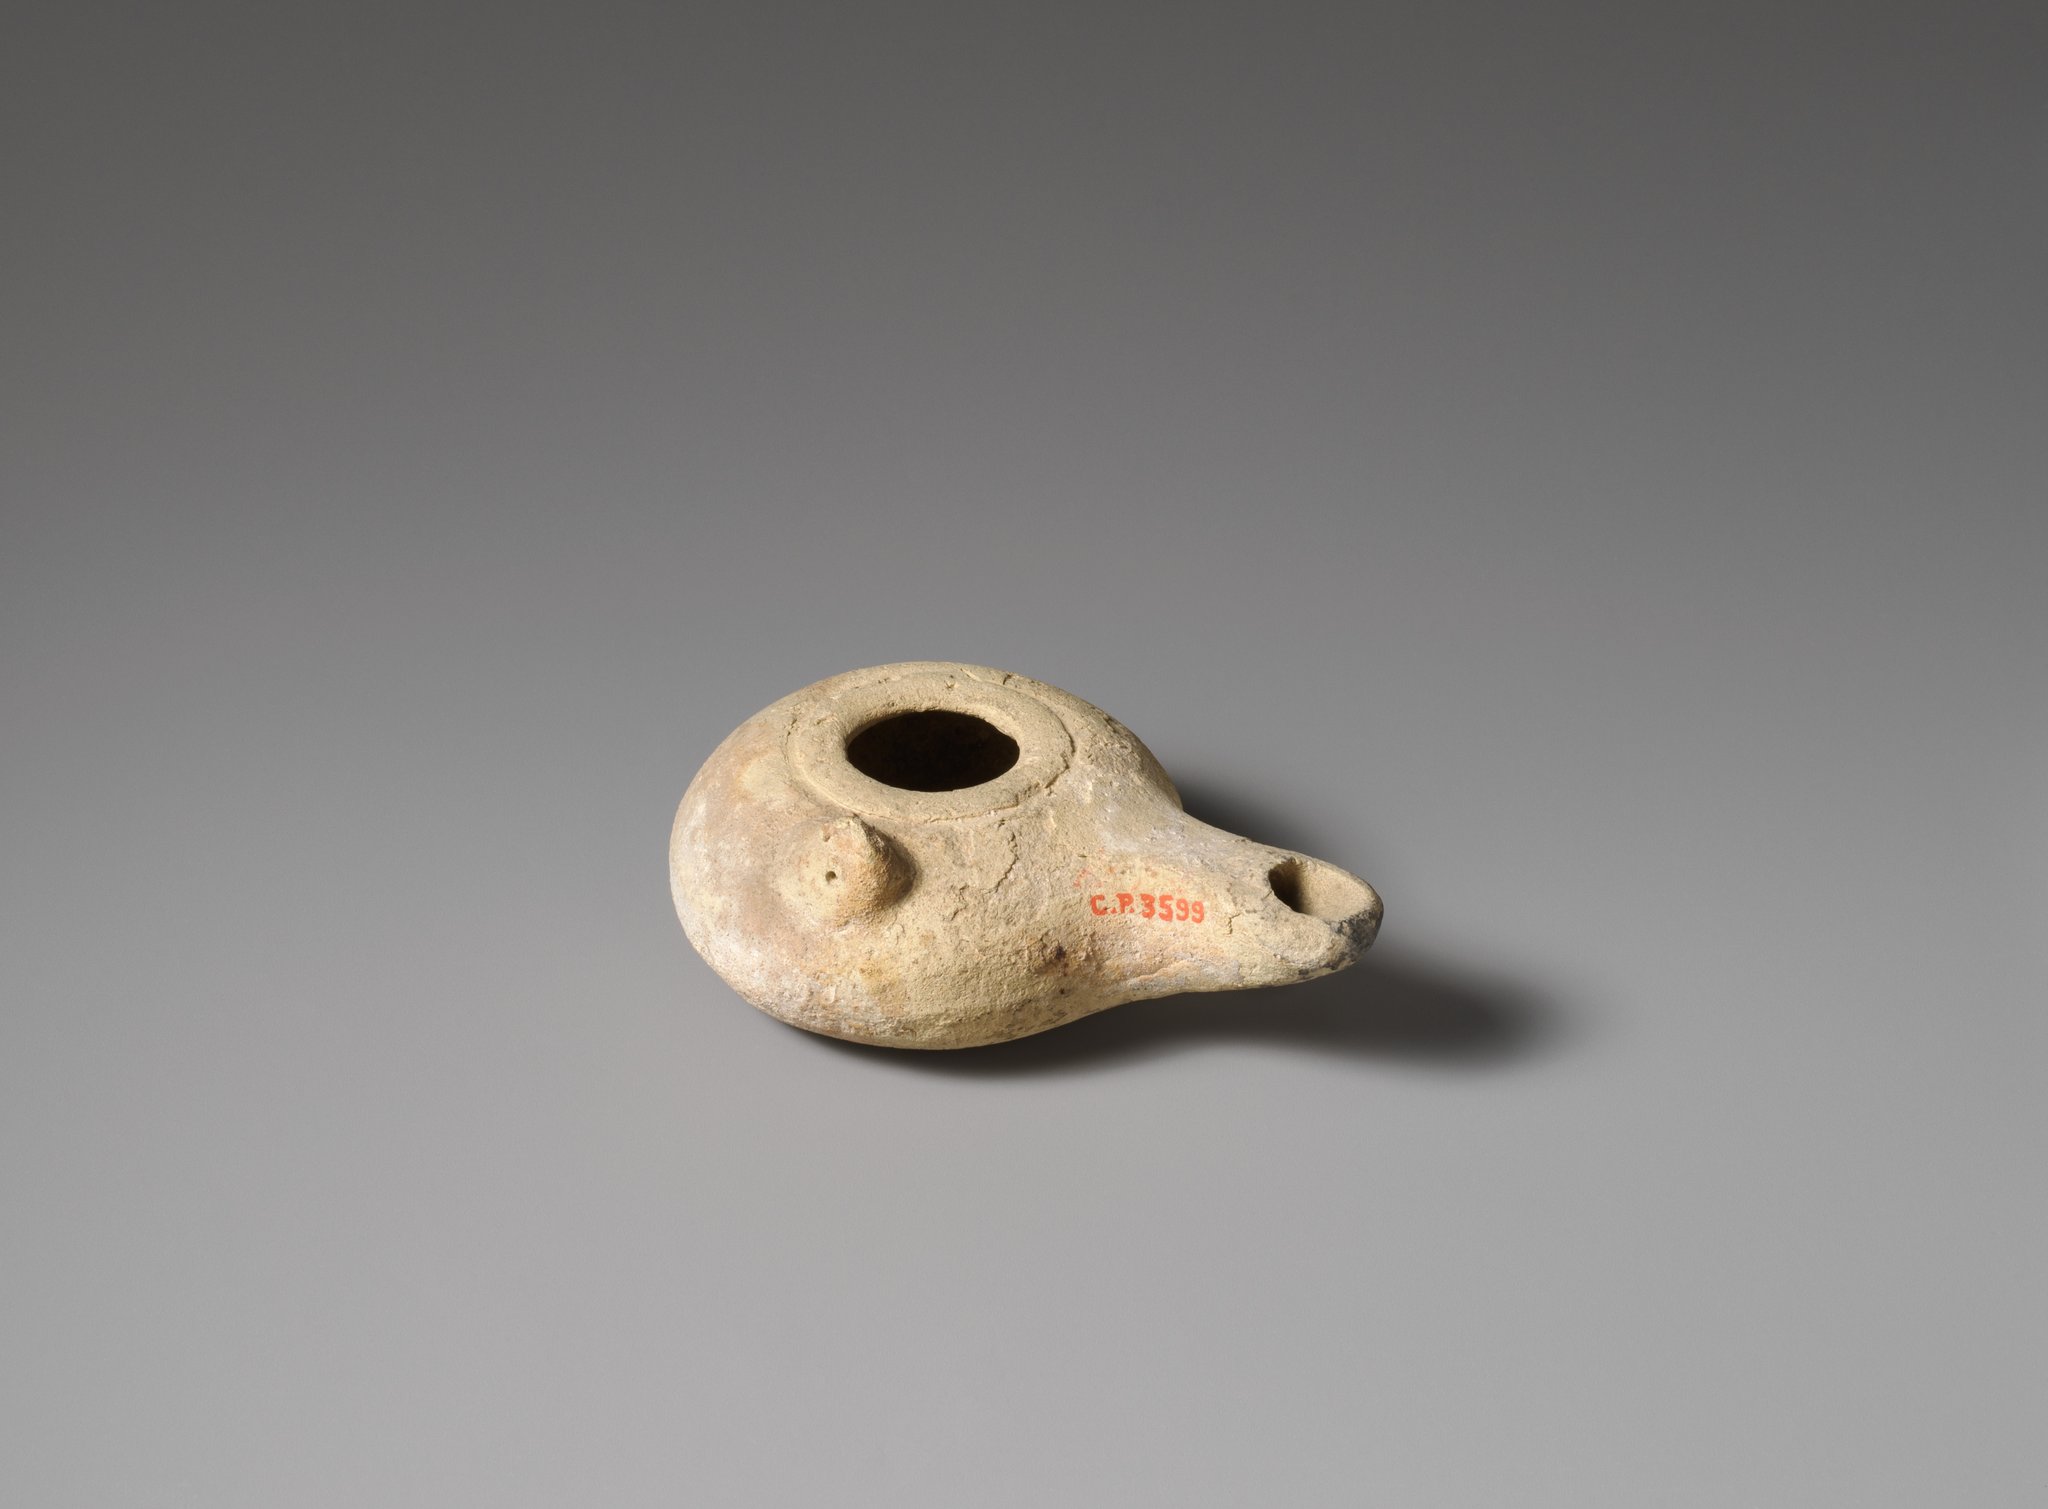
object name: lamp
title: Terracotta oil lamp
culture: greek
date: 7000 BCE-330 CE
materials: terracotta